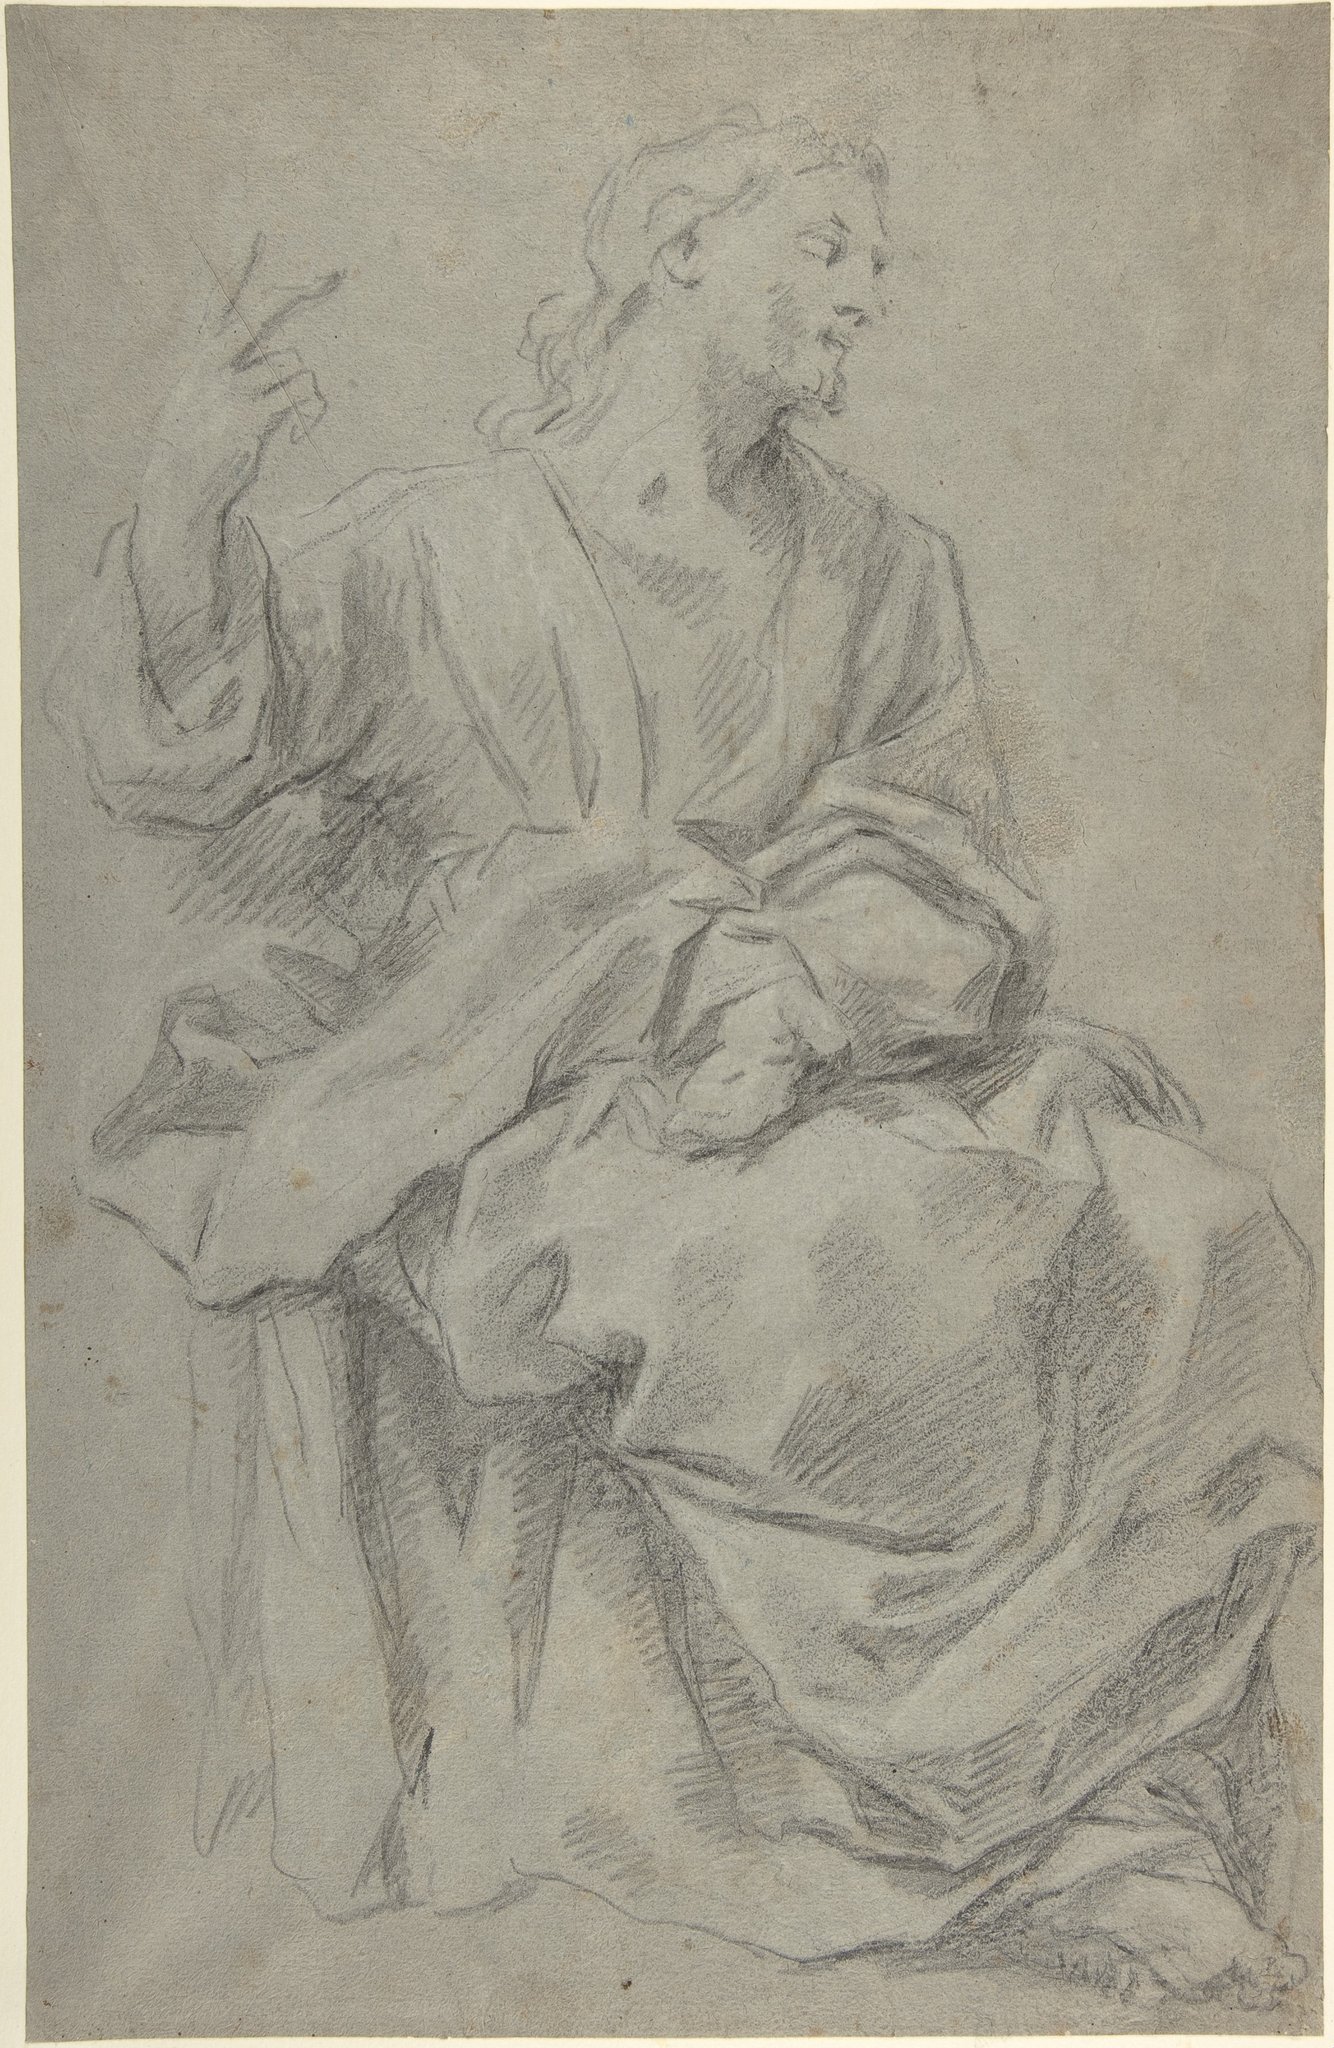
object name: drawing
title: Seated Draped Male Figure (recto); Rough Studies of Putti (verso)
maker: giovanni lanfranco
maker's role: artist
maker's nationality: italian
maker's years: 1582-1647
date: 1582-1647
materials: chalk, paper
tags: men